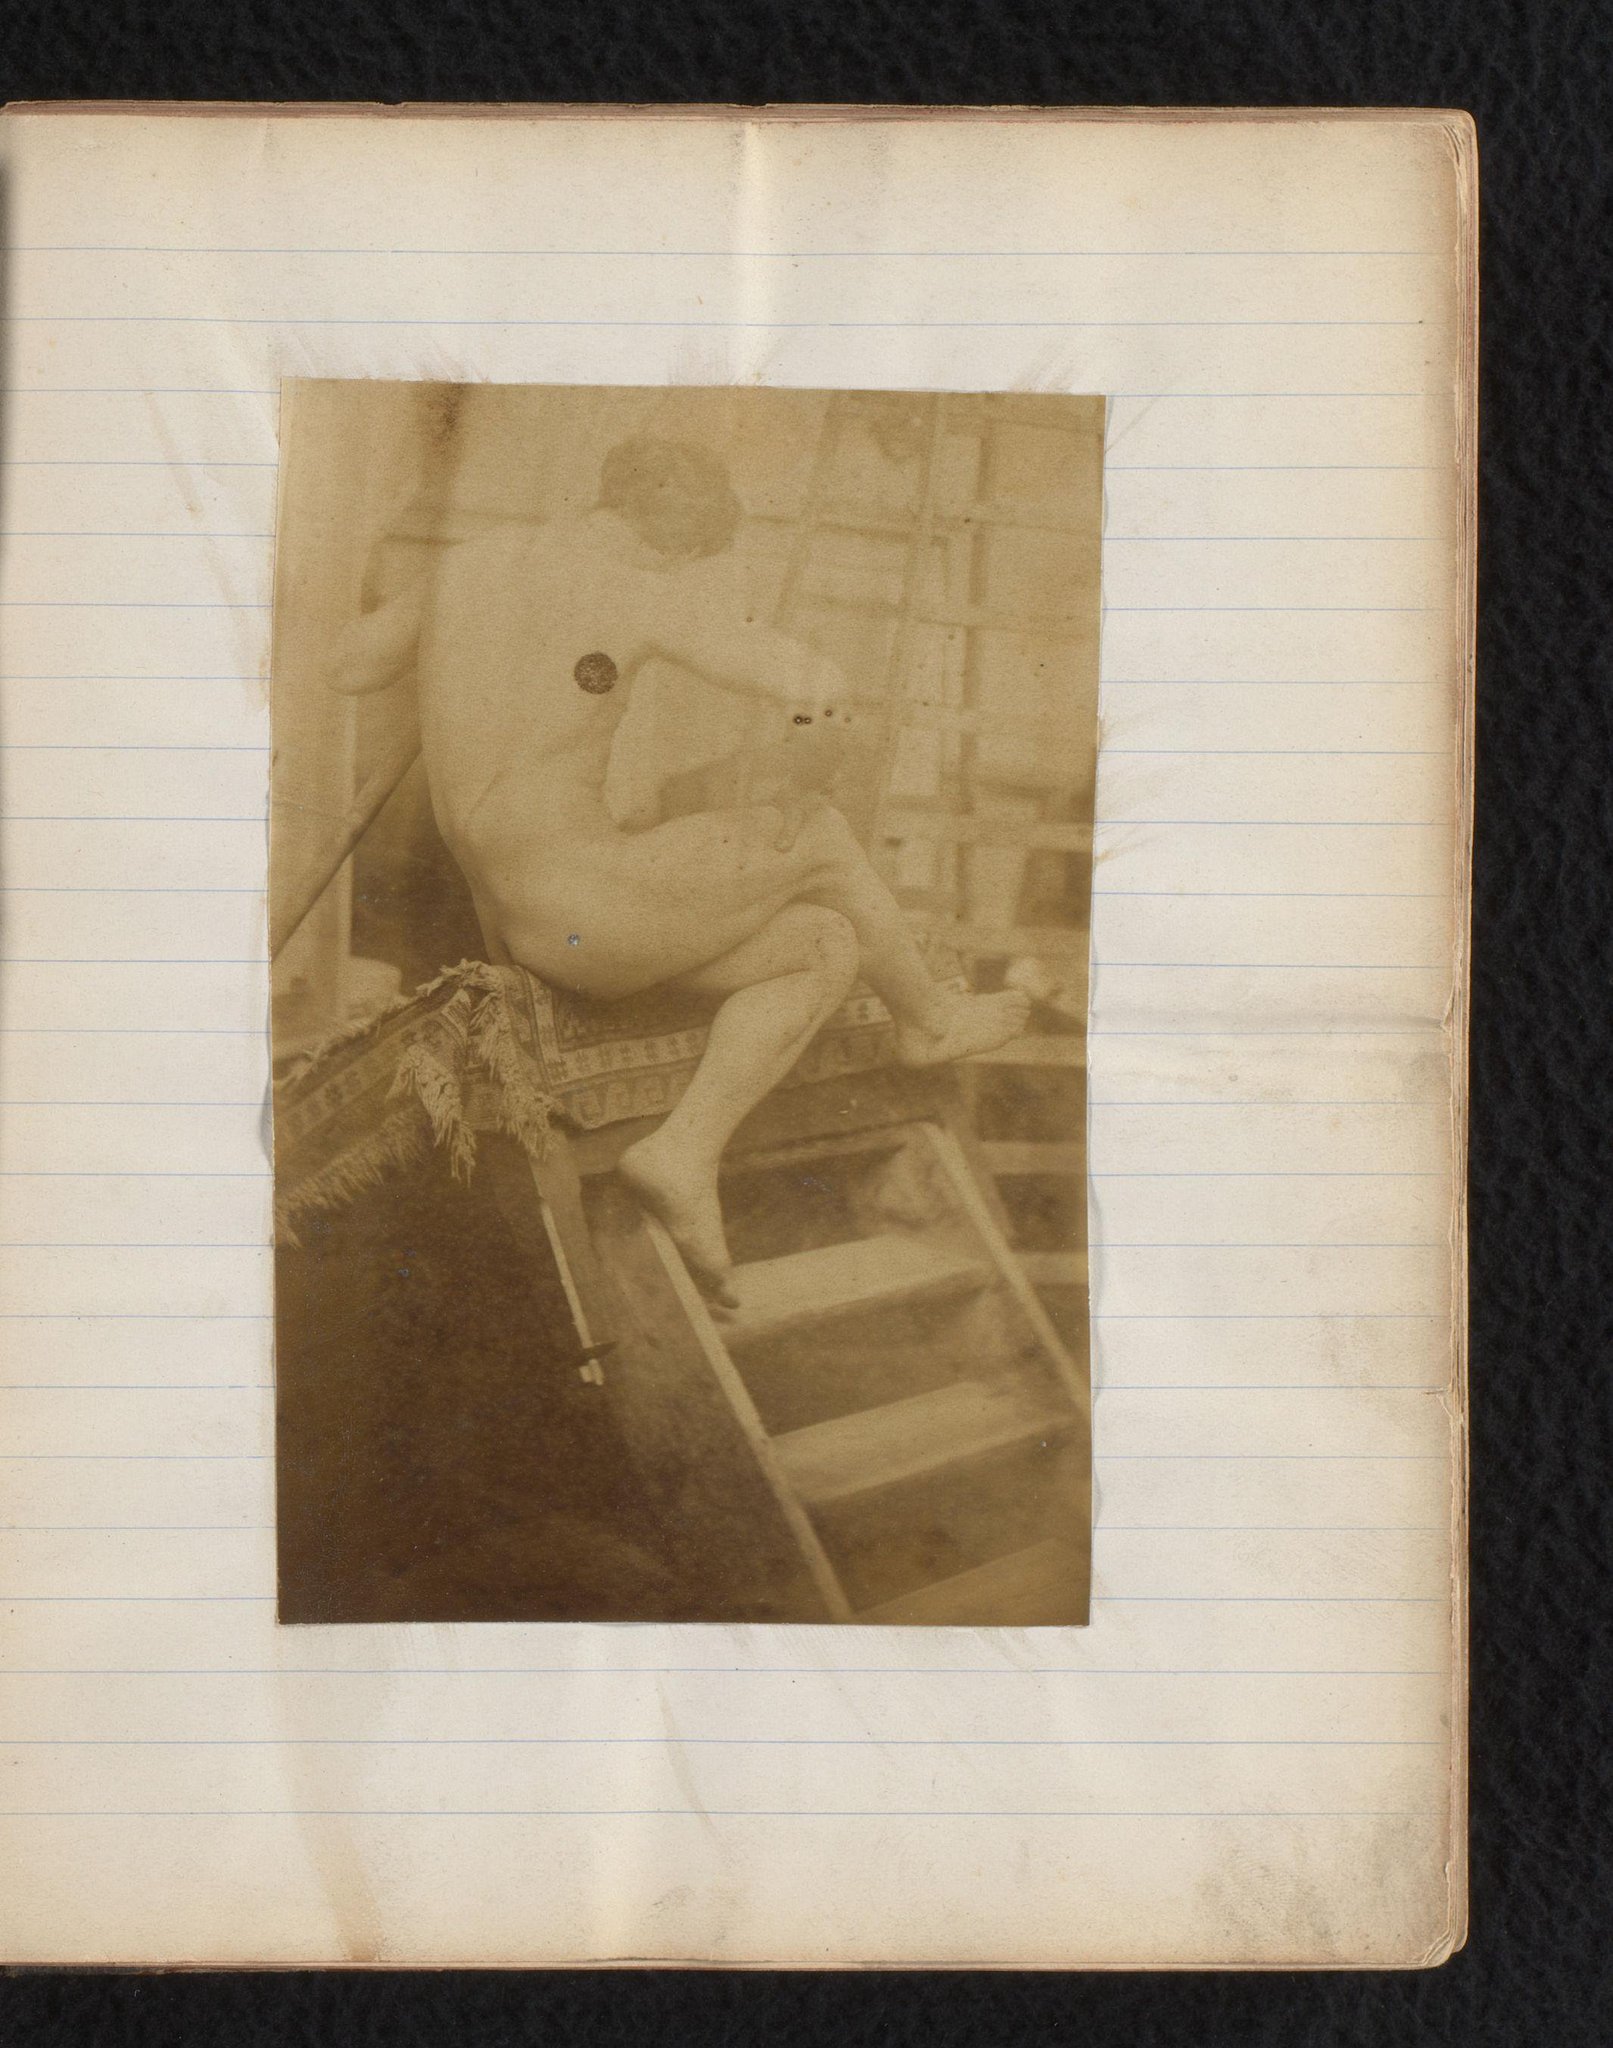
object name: photograph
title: Studie van een mannelijk naaktmodel, op de rug gezien en gezeten op een trapje in atelier van Jacques de Lalaing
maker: jacques lalaing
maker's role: painter, sculptor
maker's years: 1858-1917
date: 1883-1914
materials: paper, photographic support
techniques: albumen print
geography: brussels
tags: adult man, artist (in general) working from nude model